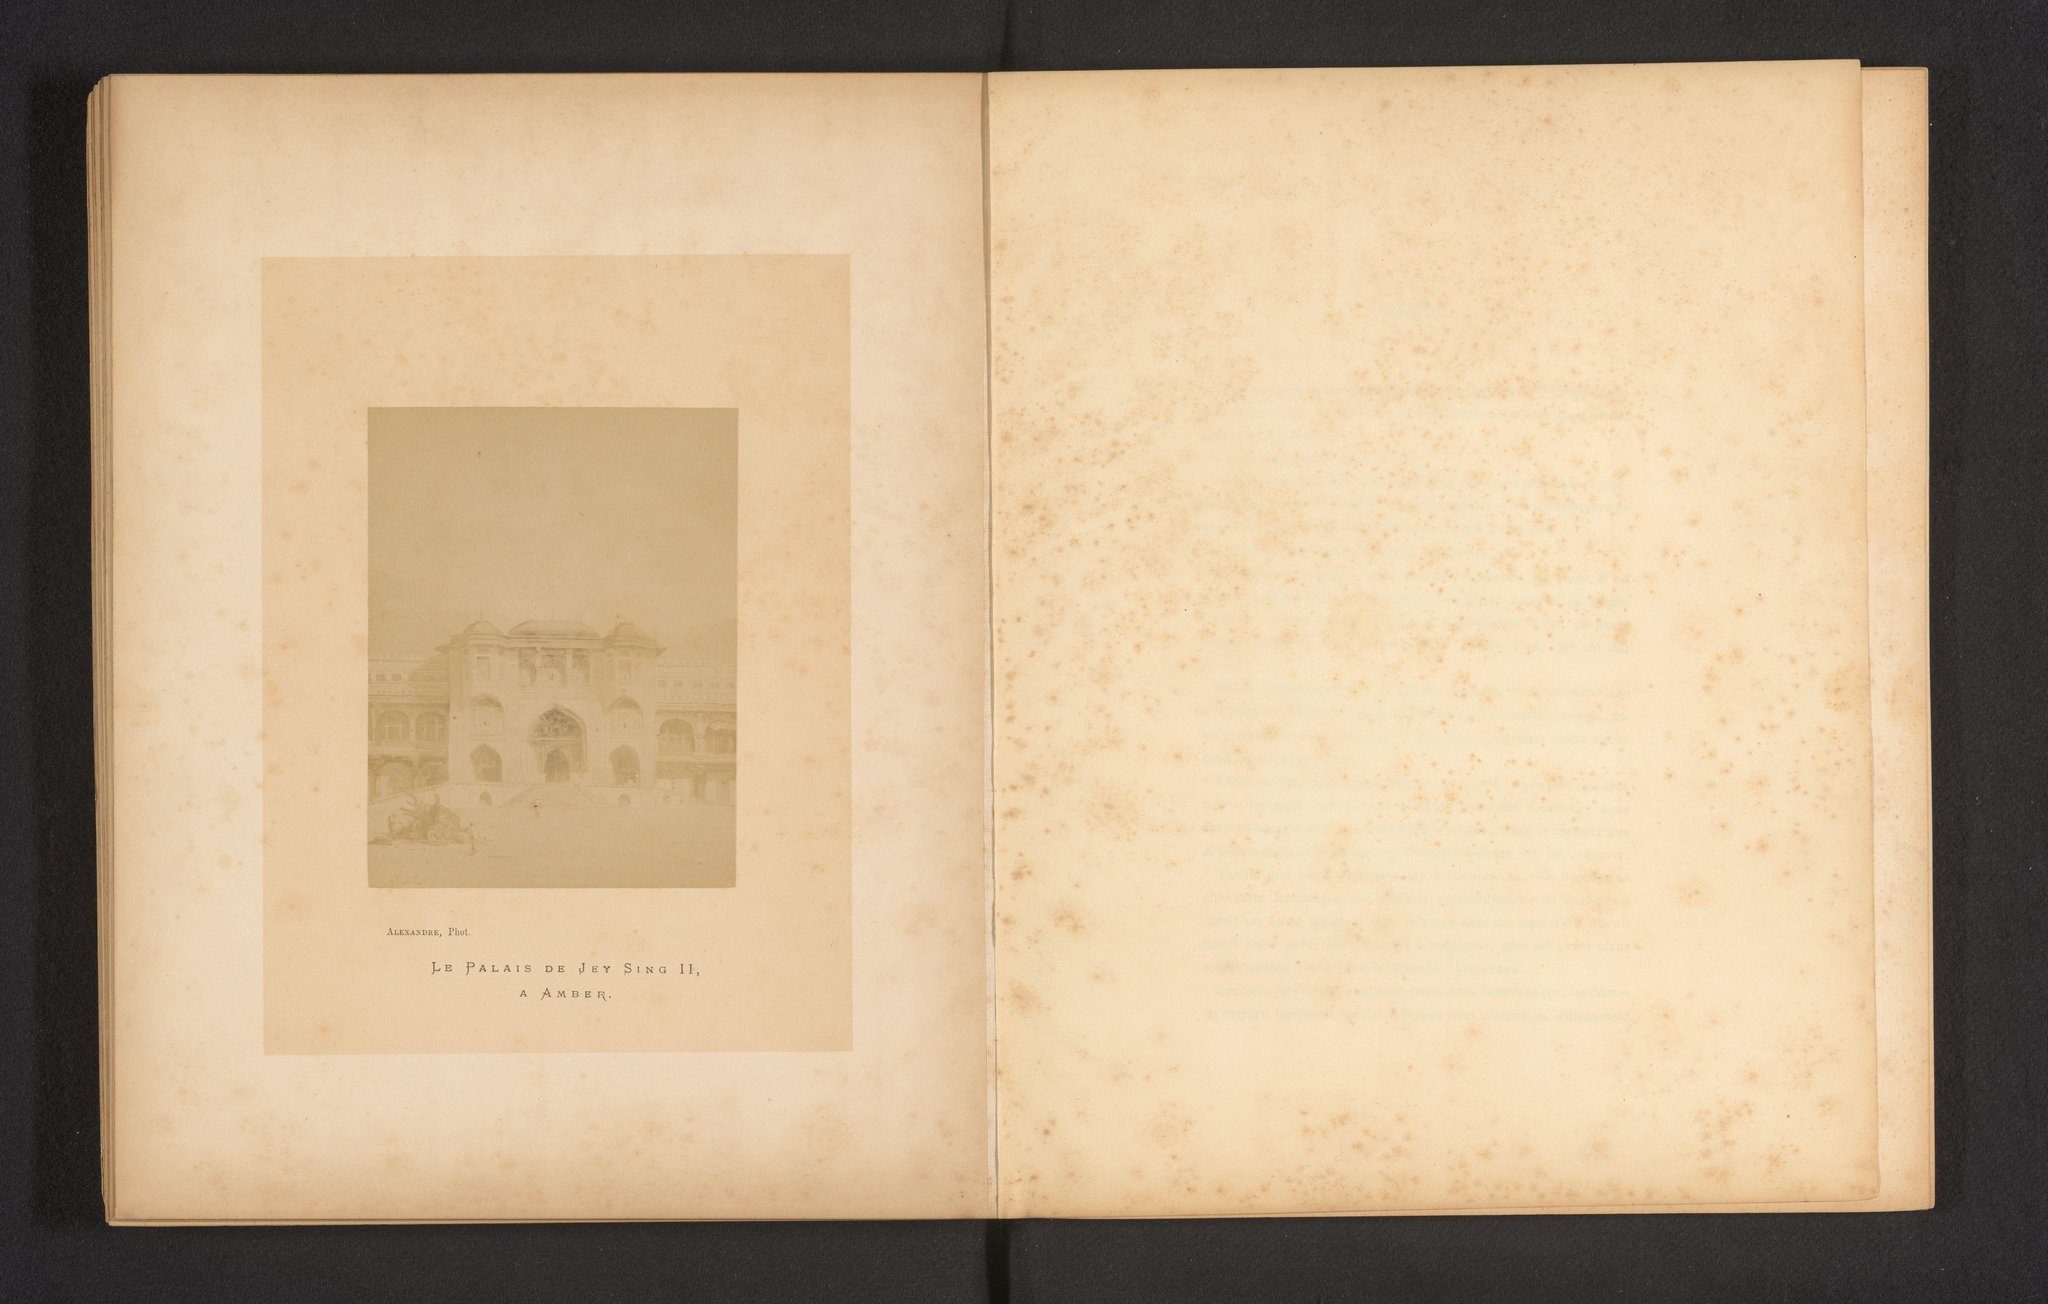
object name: reproduction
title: Le Palais de Jey Sing II, a Amber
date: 1880-1885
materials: photographic support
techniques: albumen print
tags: palace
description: Foto tegenover pagina 103, achter omslag.